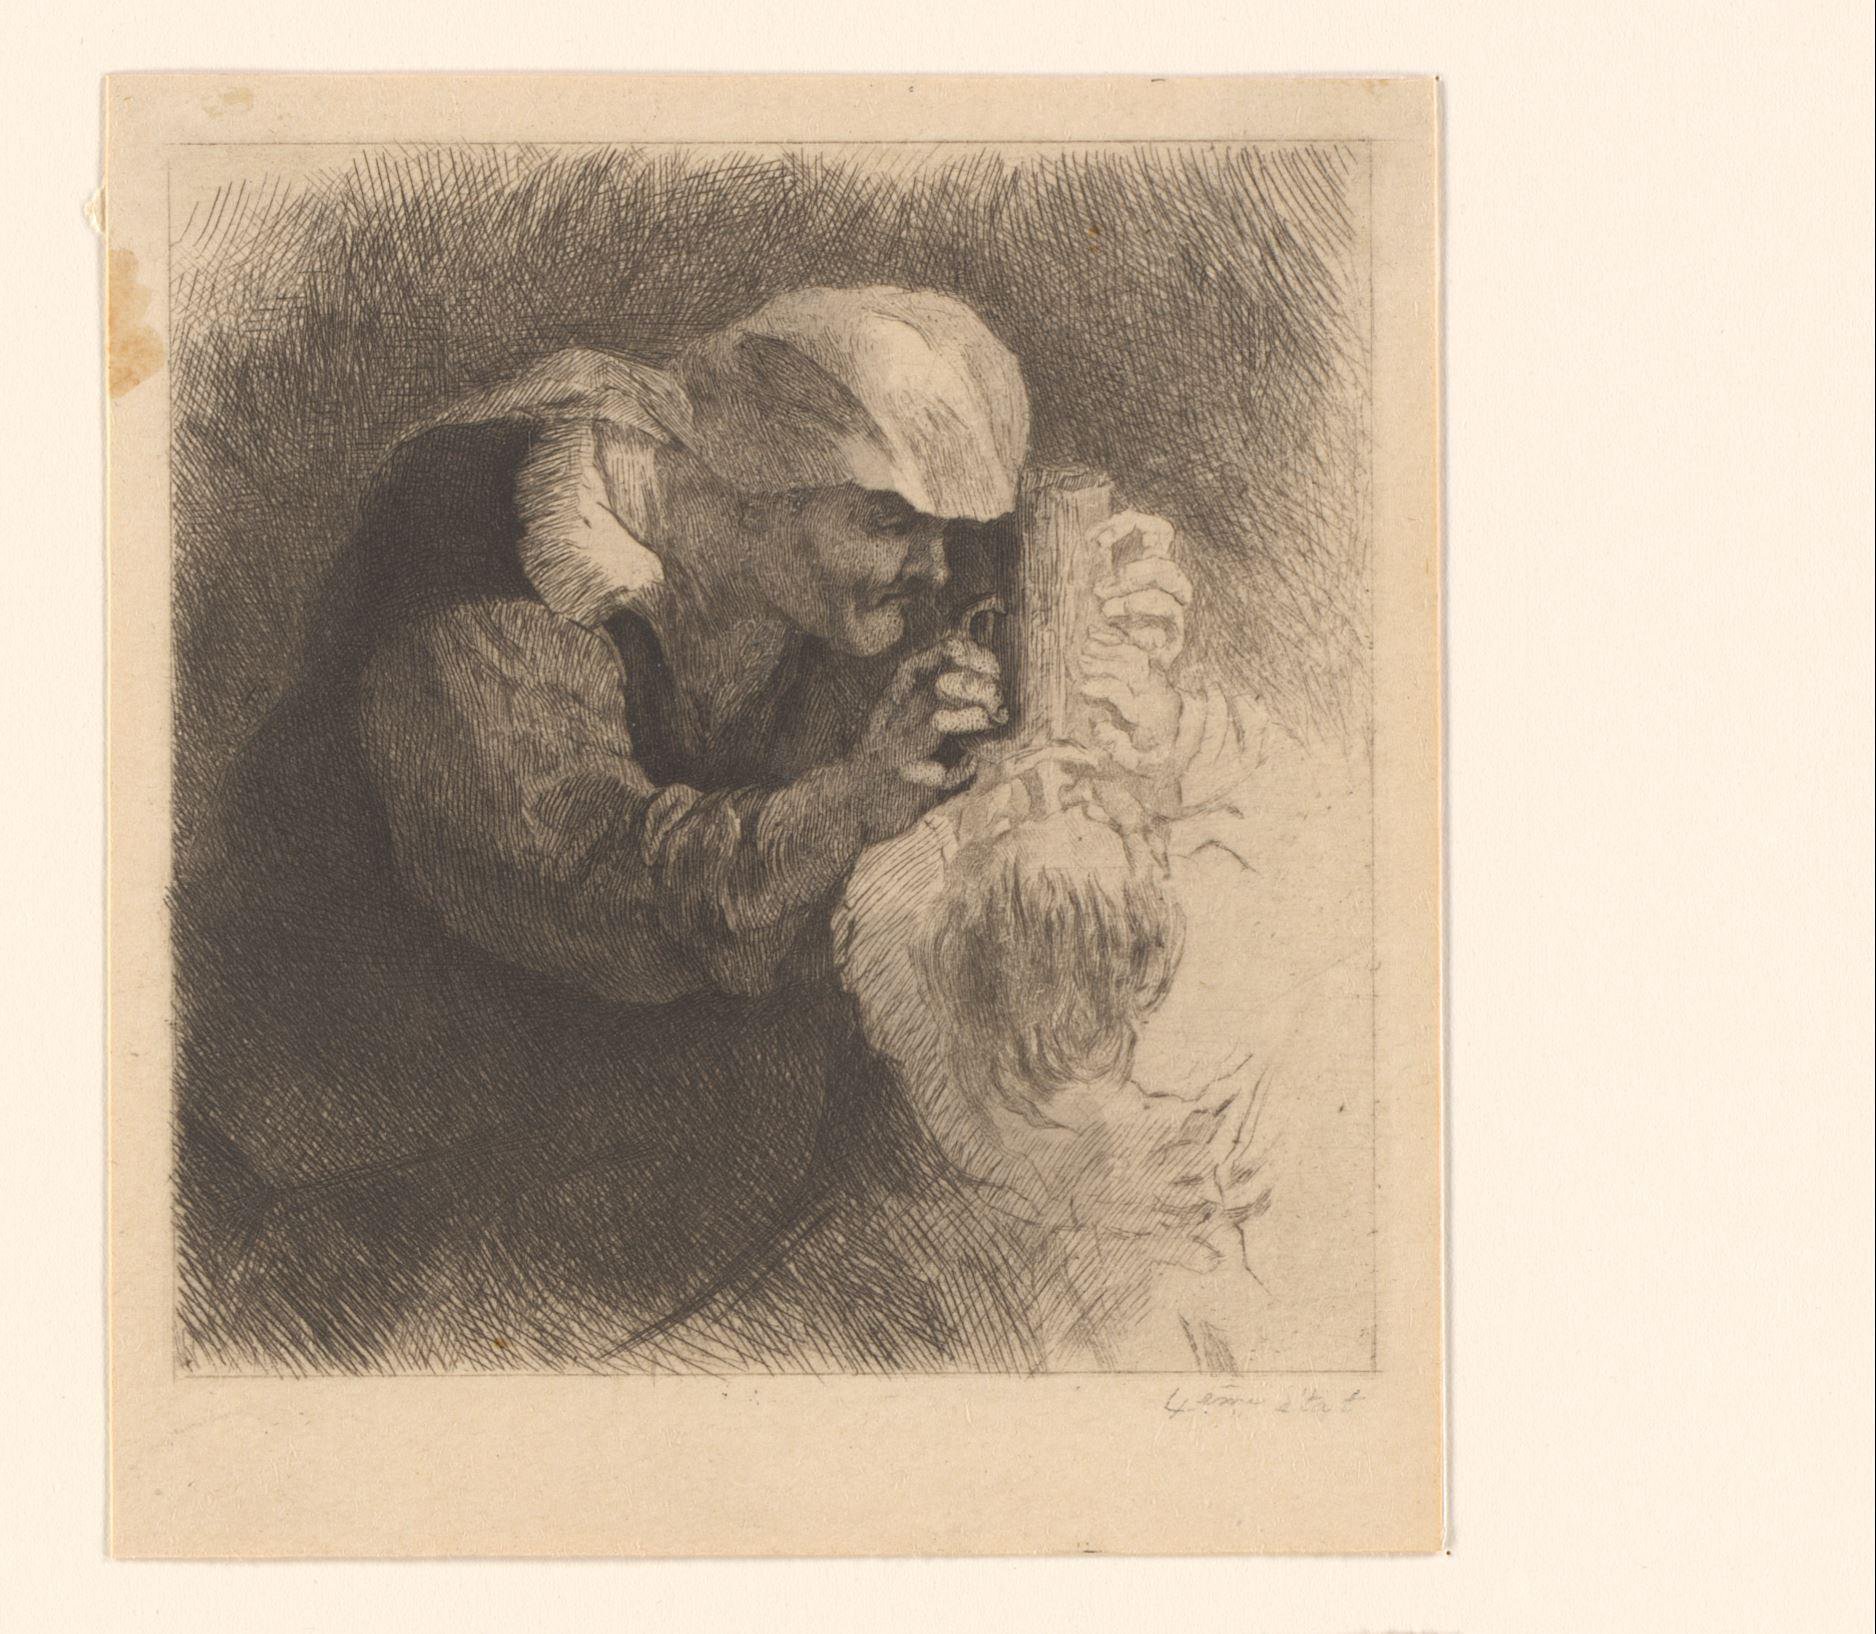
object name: print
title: Oude vrouw voedt een kind met een fles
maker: auguste danse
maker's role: print maker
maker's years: 1829-1929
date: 1839-1909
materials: paper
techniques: etching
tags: old woman, feeding a baby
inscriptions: annotation: ‘4ème état’, collector's mark, o: Lugt 2228